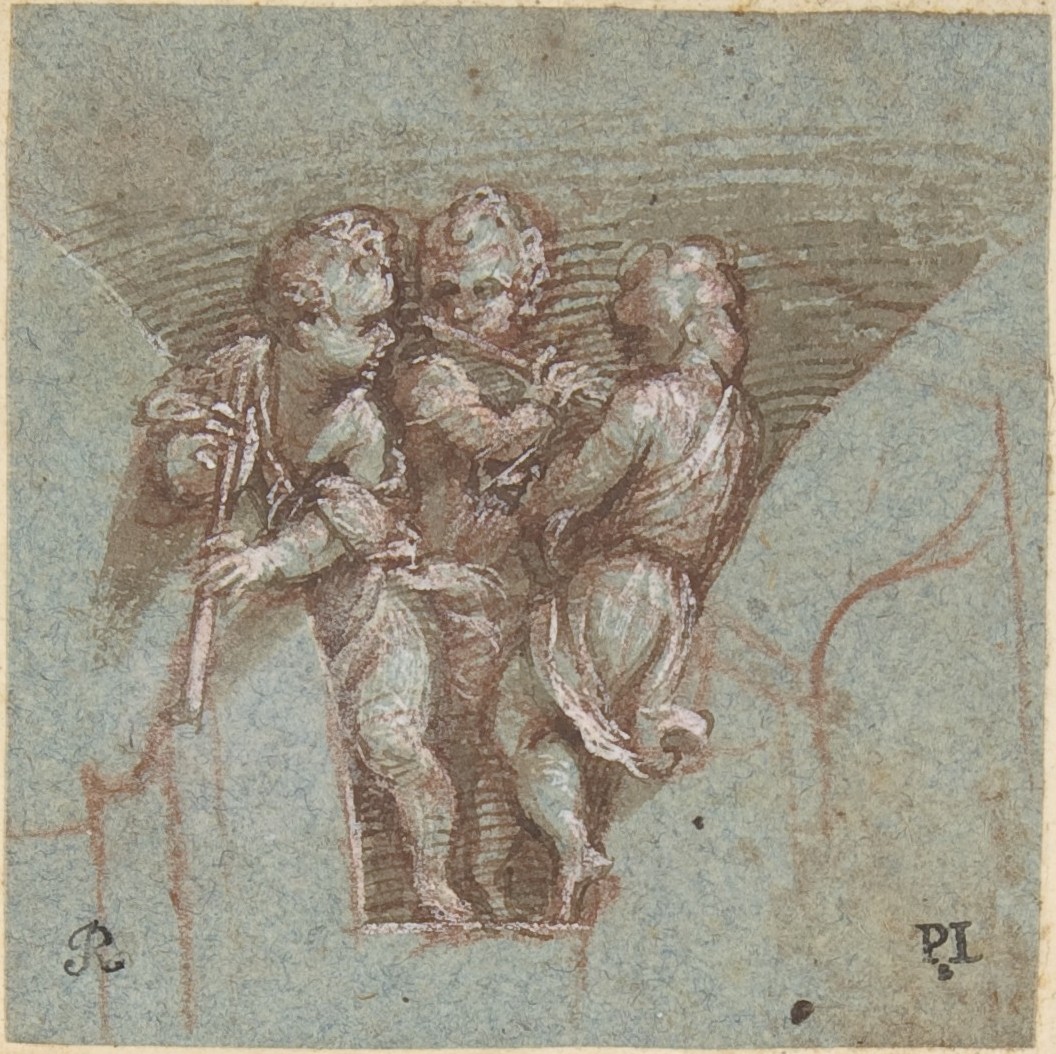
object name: drawing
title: Design for a Pendentive: Youthful Musicians with Wind Instruments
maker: pomponio amalteo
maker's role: artist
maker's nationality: italian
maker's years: 1505-1588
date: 1505-1588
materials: chalk, ink, paper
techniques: brush, highlighting, pen, wash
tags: flutes,musicians